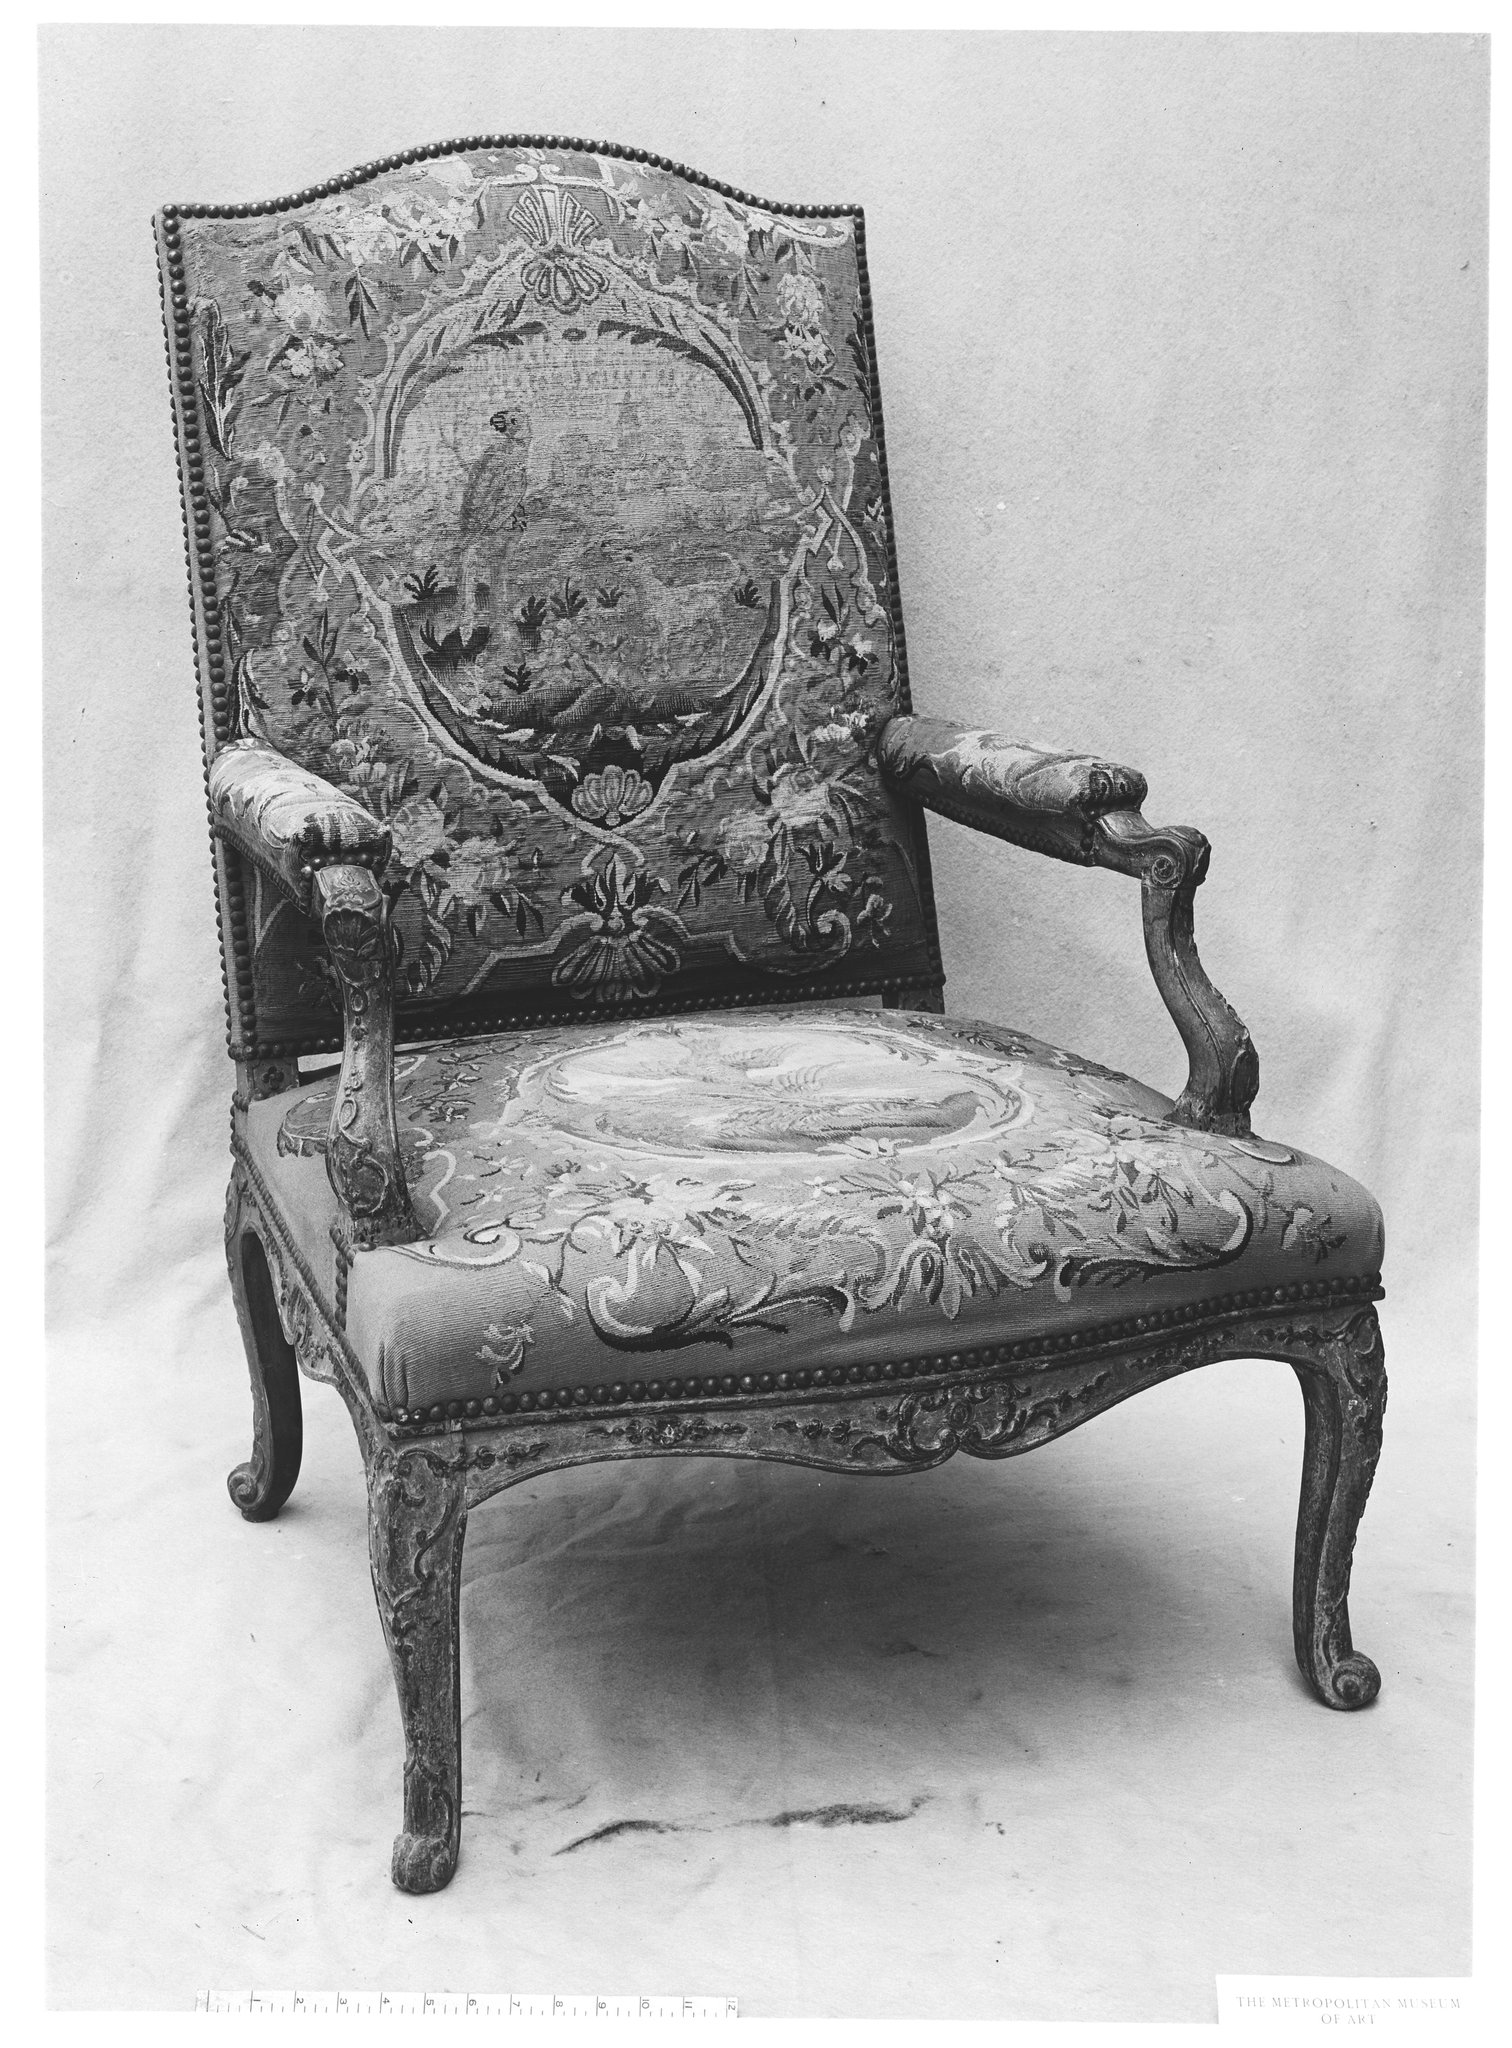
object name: armchair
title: Armchair (fauteuil)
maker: aubusson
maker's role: factory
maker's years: 1665-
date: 1701-1725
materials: wood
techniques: carving, tapestry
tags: animals,birds,flowers